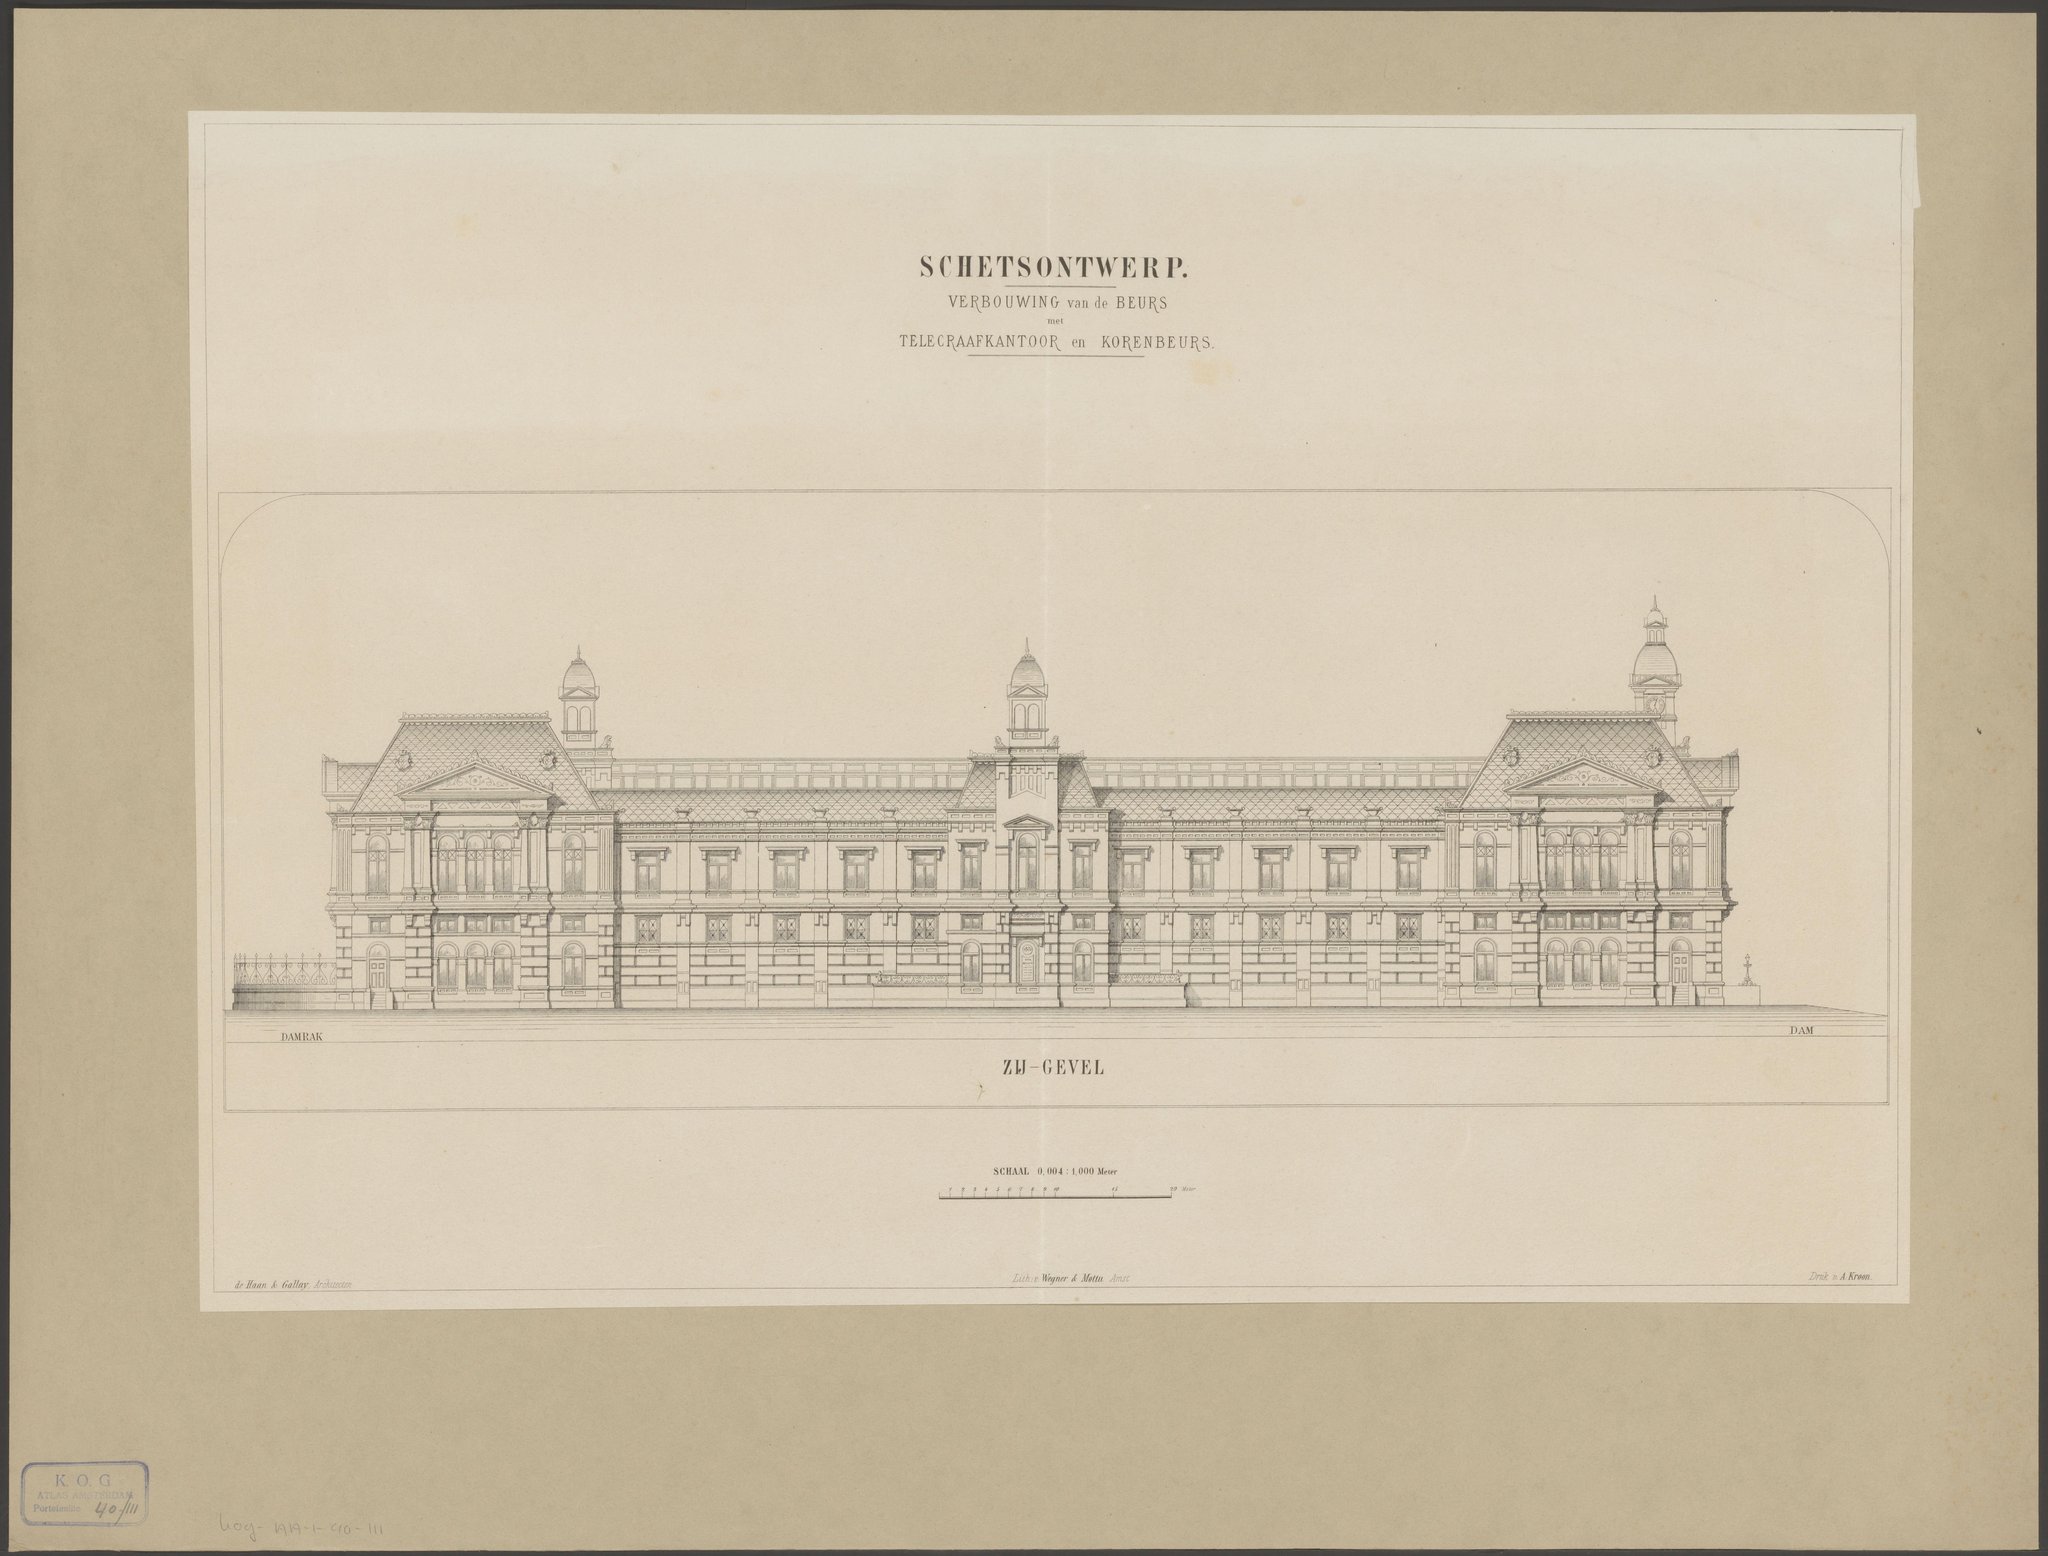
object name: print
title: Ontwerp voor de zijgevel van een nieuwe beurs in Amsterdam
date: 1870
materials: paper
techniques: lithograph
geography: amsterdam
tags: stock exchange, stock-market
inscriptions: collector's mark: Lugt 1641b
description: Prent genoemd en gedateerd in: Catalogus van de bibliotheek der stad Amsterdam. Amsterdam: Stadsdrukkerij, 1876, dl. 6, p. 539.